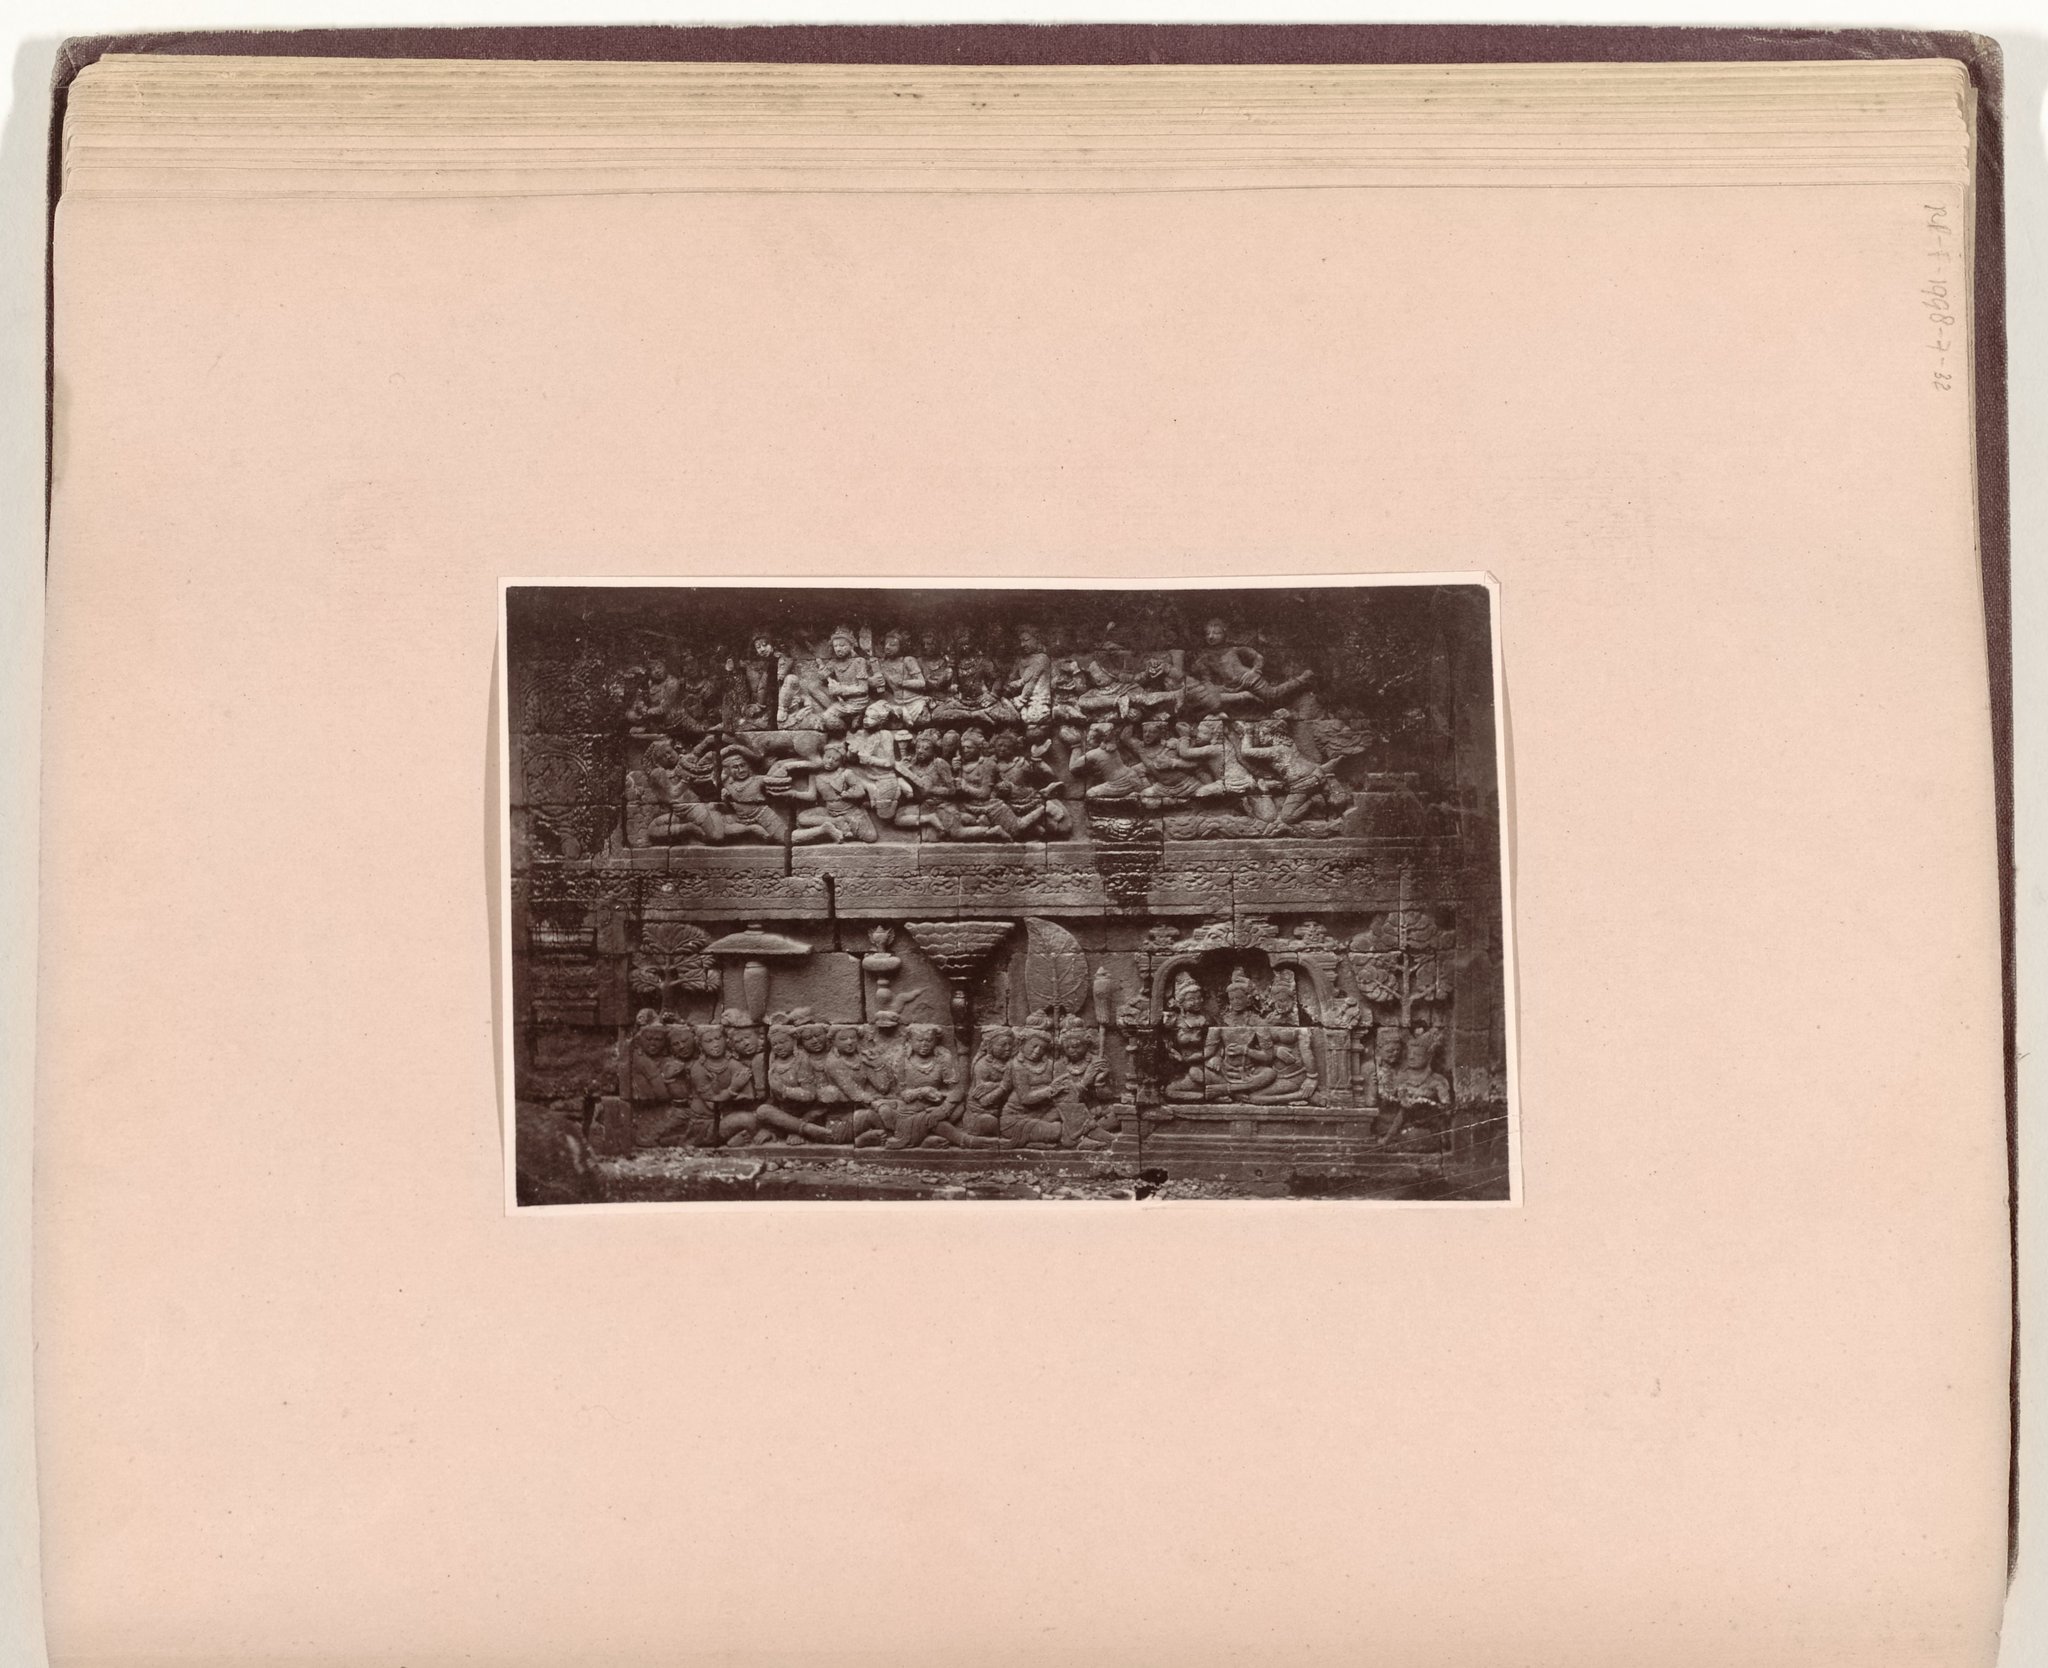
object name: album leaf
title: Reliëf van de Borobudur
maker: c. dietrich (fotograaf)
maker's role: fotograaf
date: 1875-1890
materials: cardboard, paper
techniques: albumen print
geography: java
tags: sculpture (+ relief ~ sculpture)